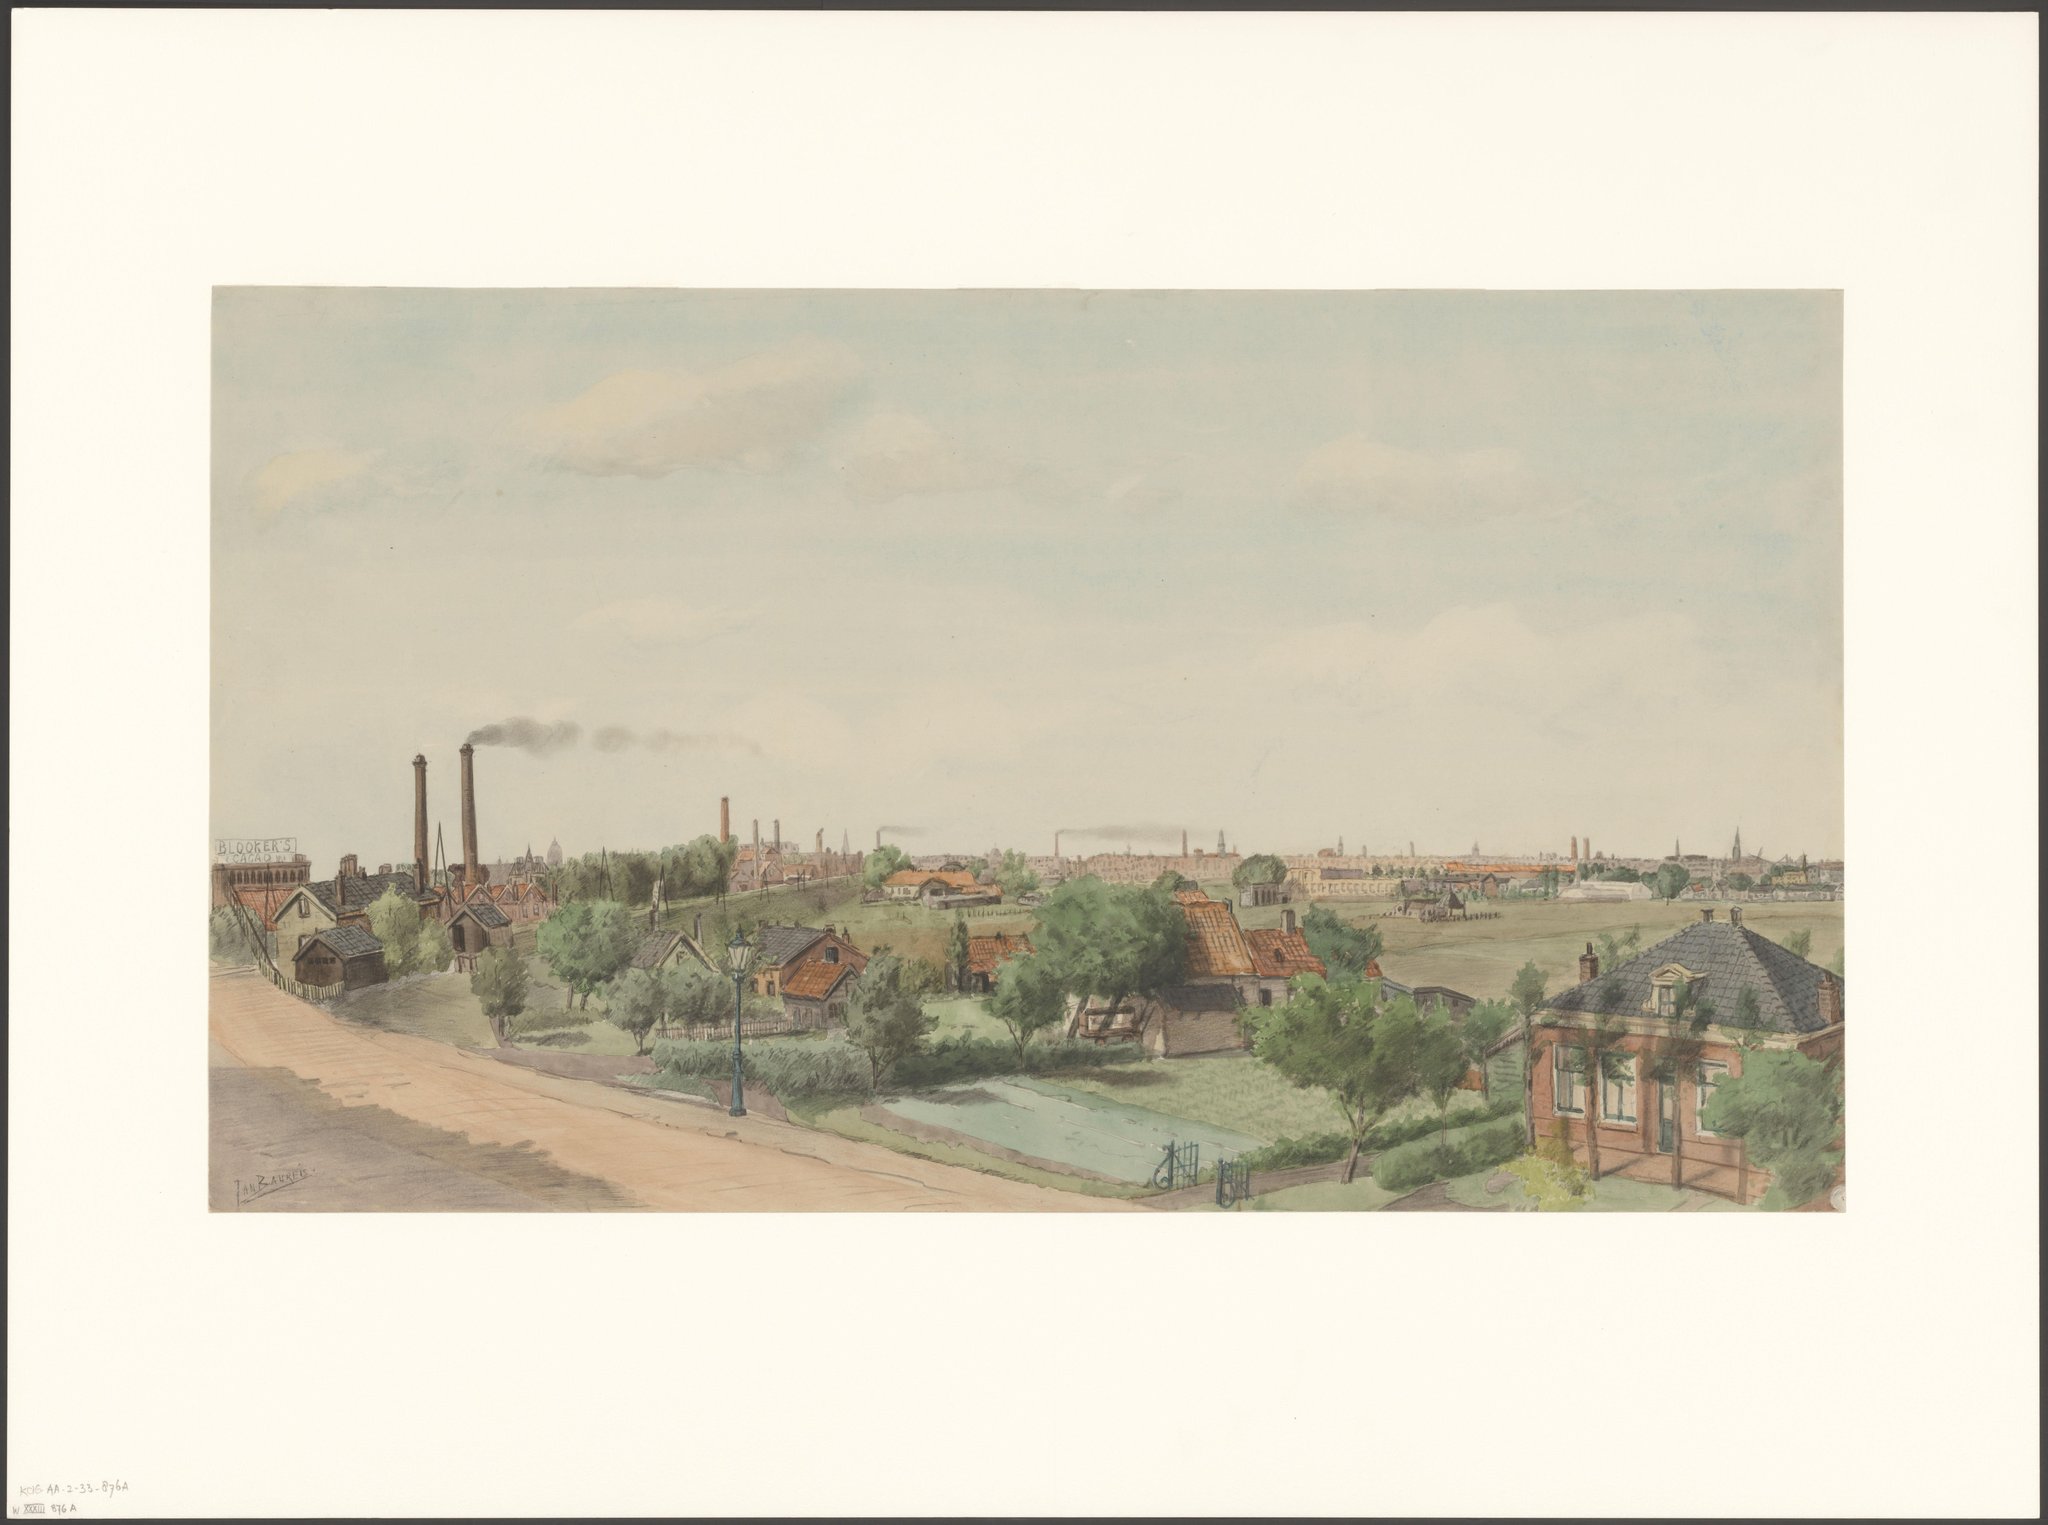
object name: drawing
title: Gezicht op de Watergraafsmeer gezien vanaf de Weesperzijde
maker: jan baureis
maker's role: draughtsman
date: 1919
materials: chalk, gouache, paper, pencil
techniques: brush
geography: amsterdam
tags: city-view in general; 'veduta', the usual house or row of houses, polder, reclaimed land, street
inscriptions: collector's mark: Lugt 800a, inscription: ‘De Watergraafsmeer ter (...) jaar -1919- / JanBaureis’, signature: ‘JanBaureis’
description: Tekening binnen de Atlas Van Eck ingedeeld op wijknummer 33.